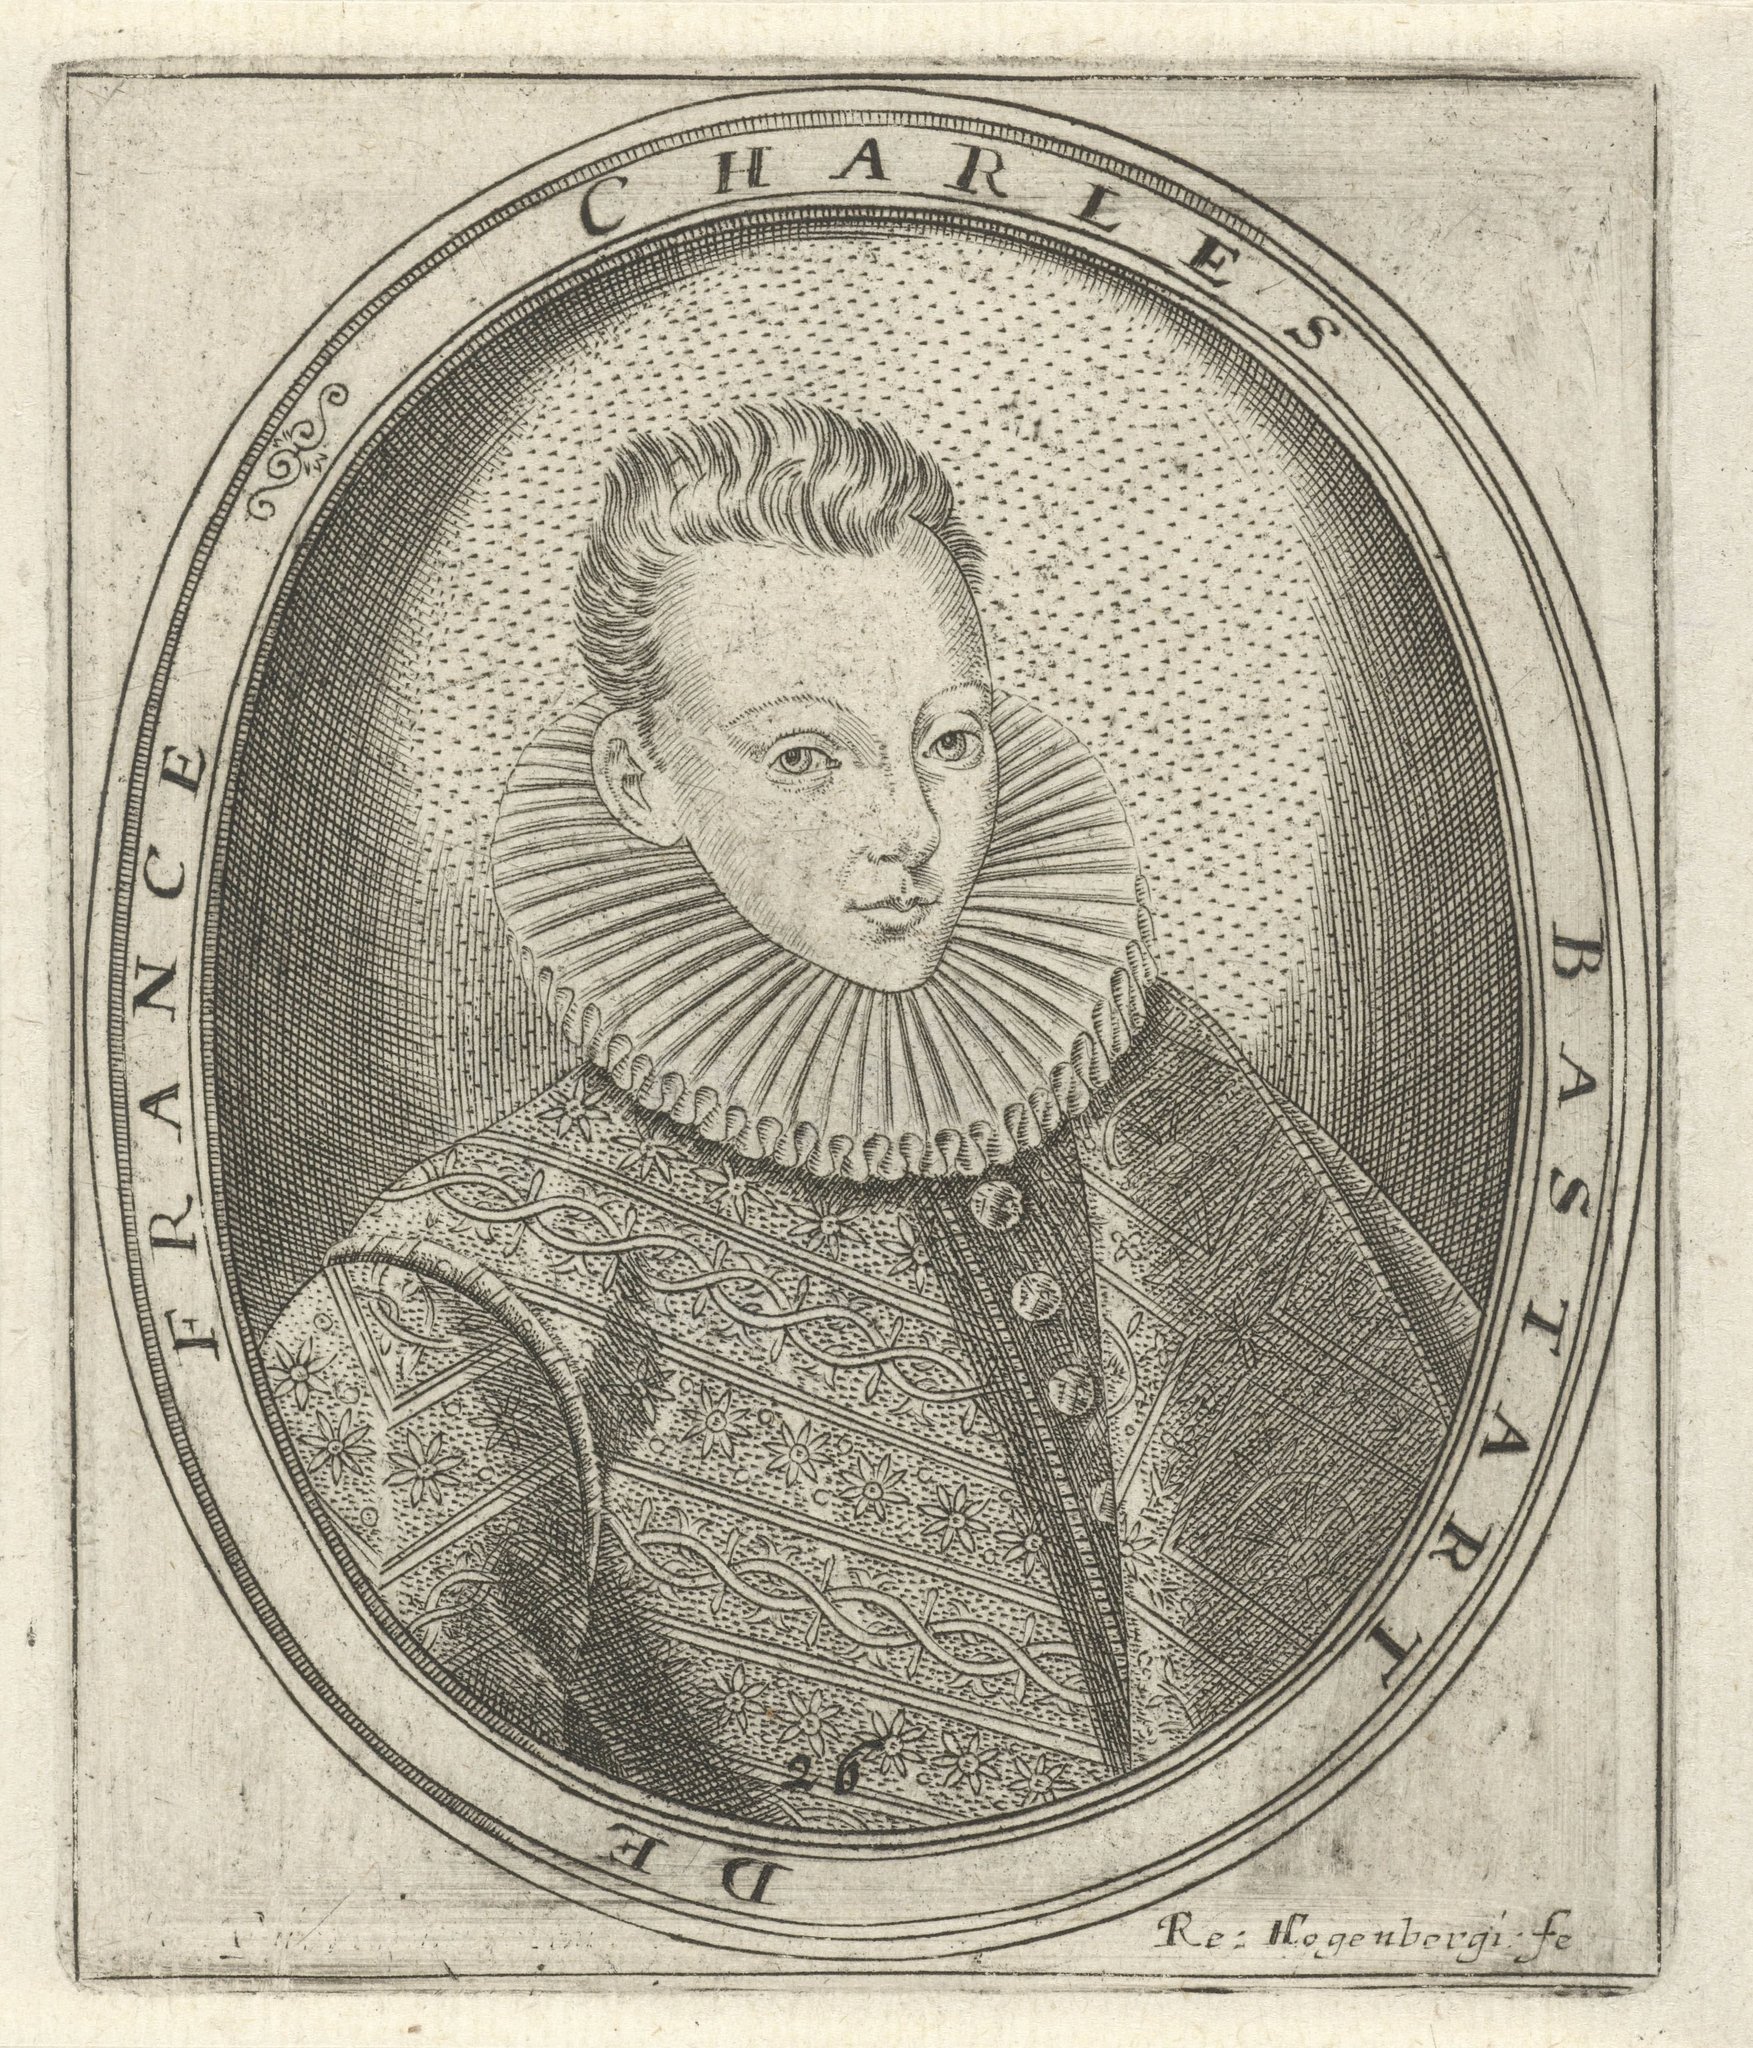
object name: print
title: Portret van Charles de Valois, hertog van Angoulême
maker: remigius hogenberg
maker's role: print maker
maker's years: 1536-1587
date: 1580-1588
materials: paper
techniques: engraving, etching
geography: southern netherlands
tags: charles de valois (hertog van angoulême)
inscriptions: collector's mark: Lugt 2228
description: Charles de Valois, hertog van Angoulême, bastaard van Charles IX van Frankrijk en zijn maîtresse Marie Touchet.